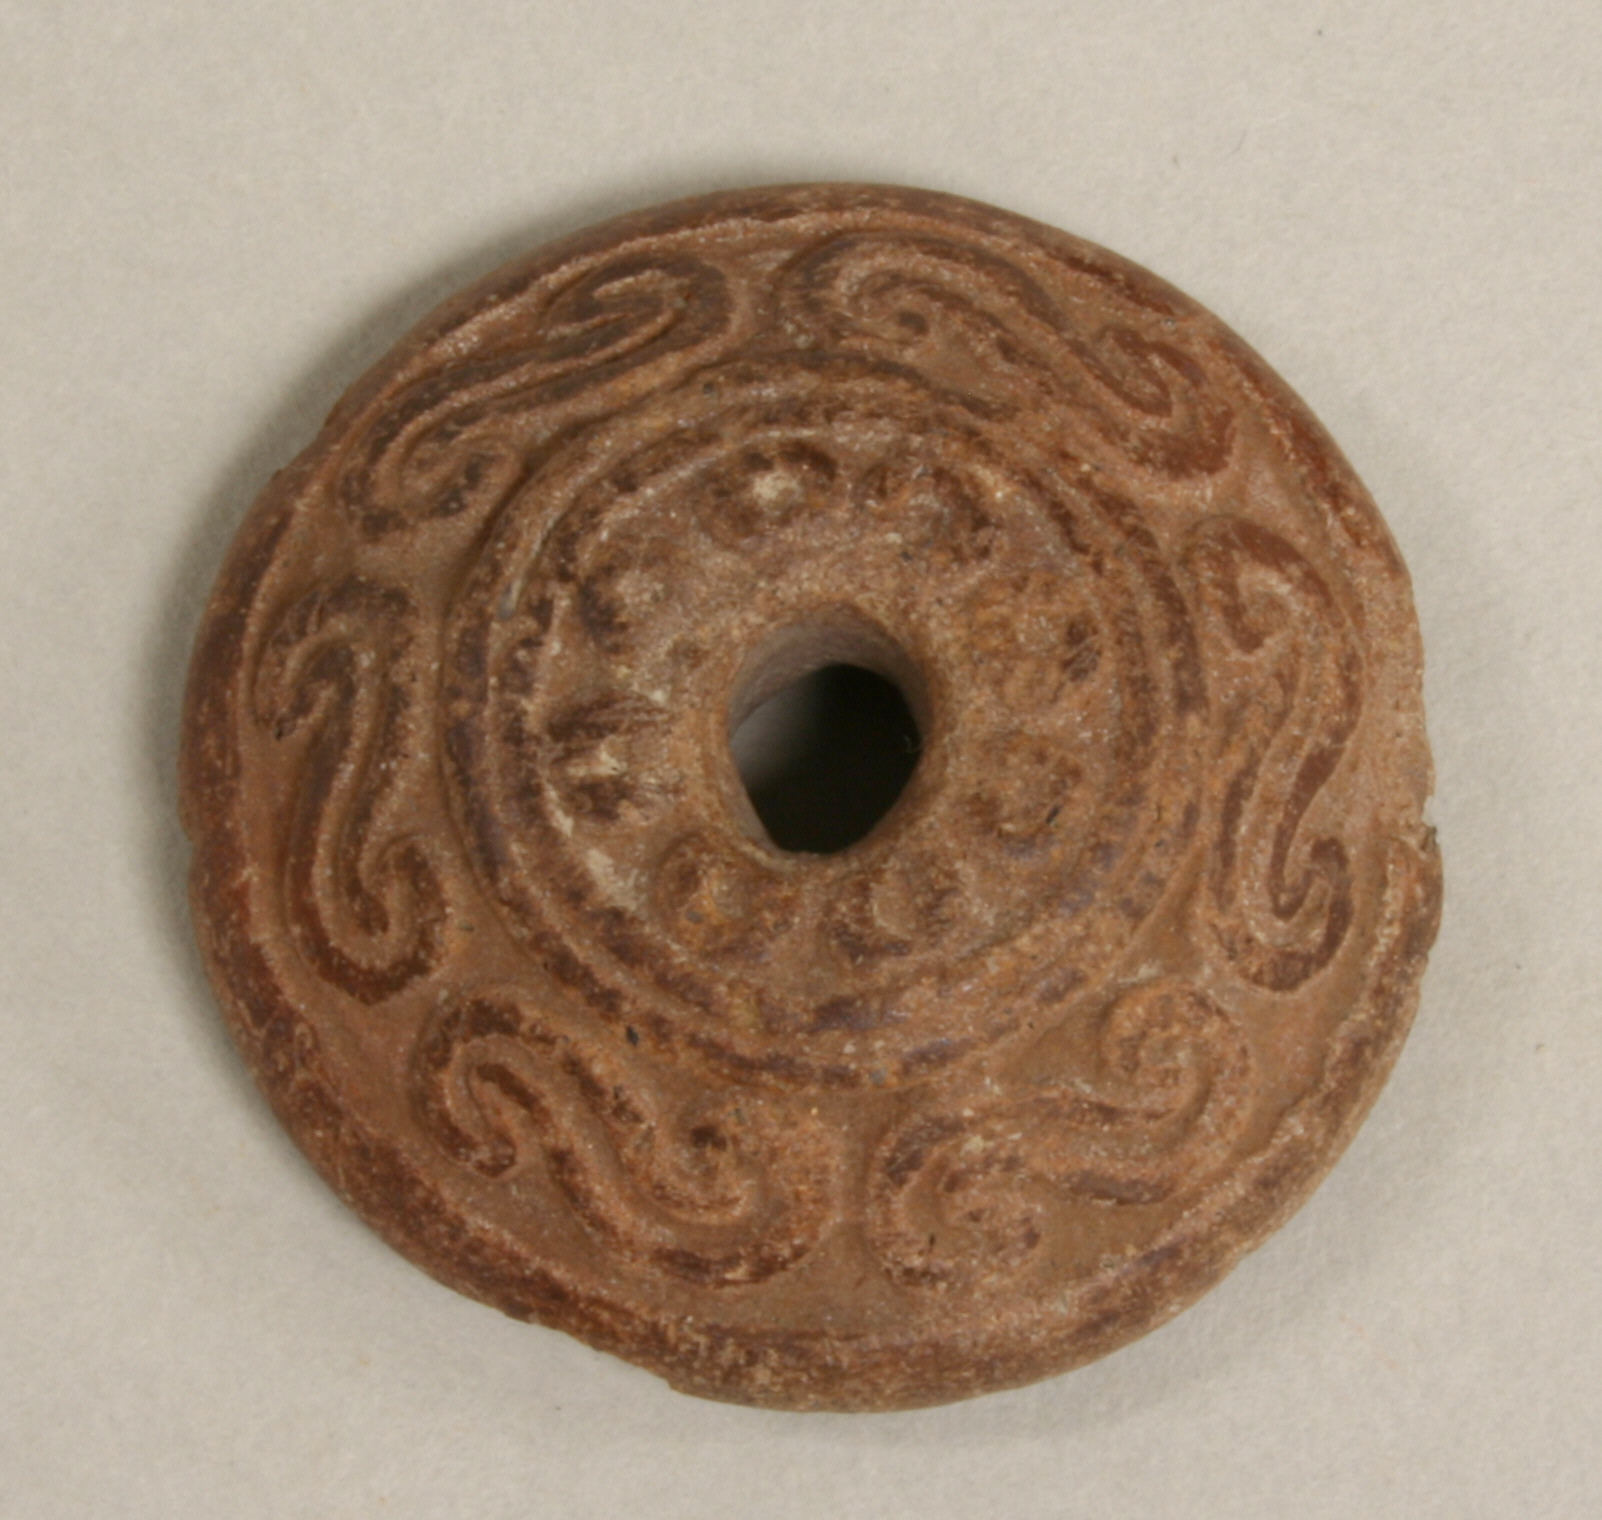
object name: spindle whorl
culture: mexican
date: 801-1500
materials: ceramic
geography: mexico